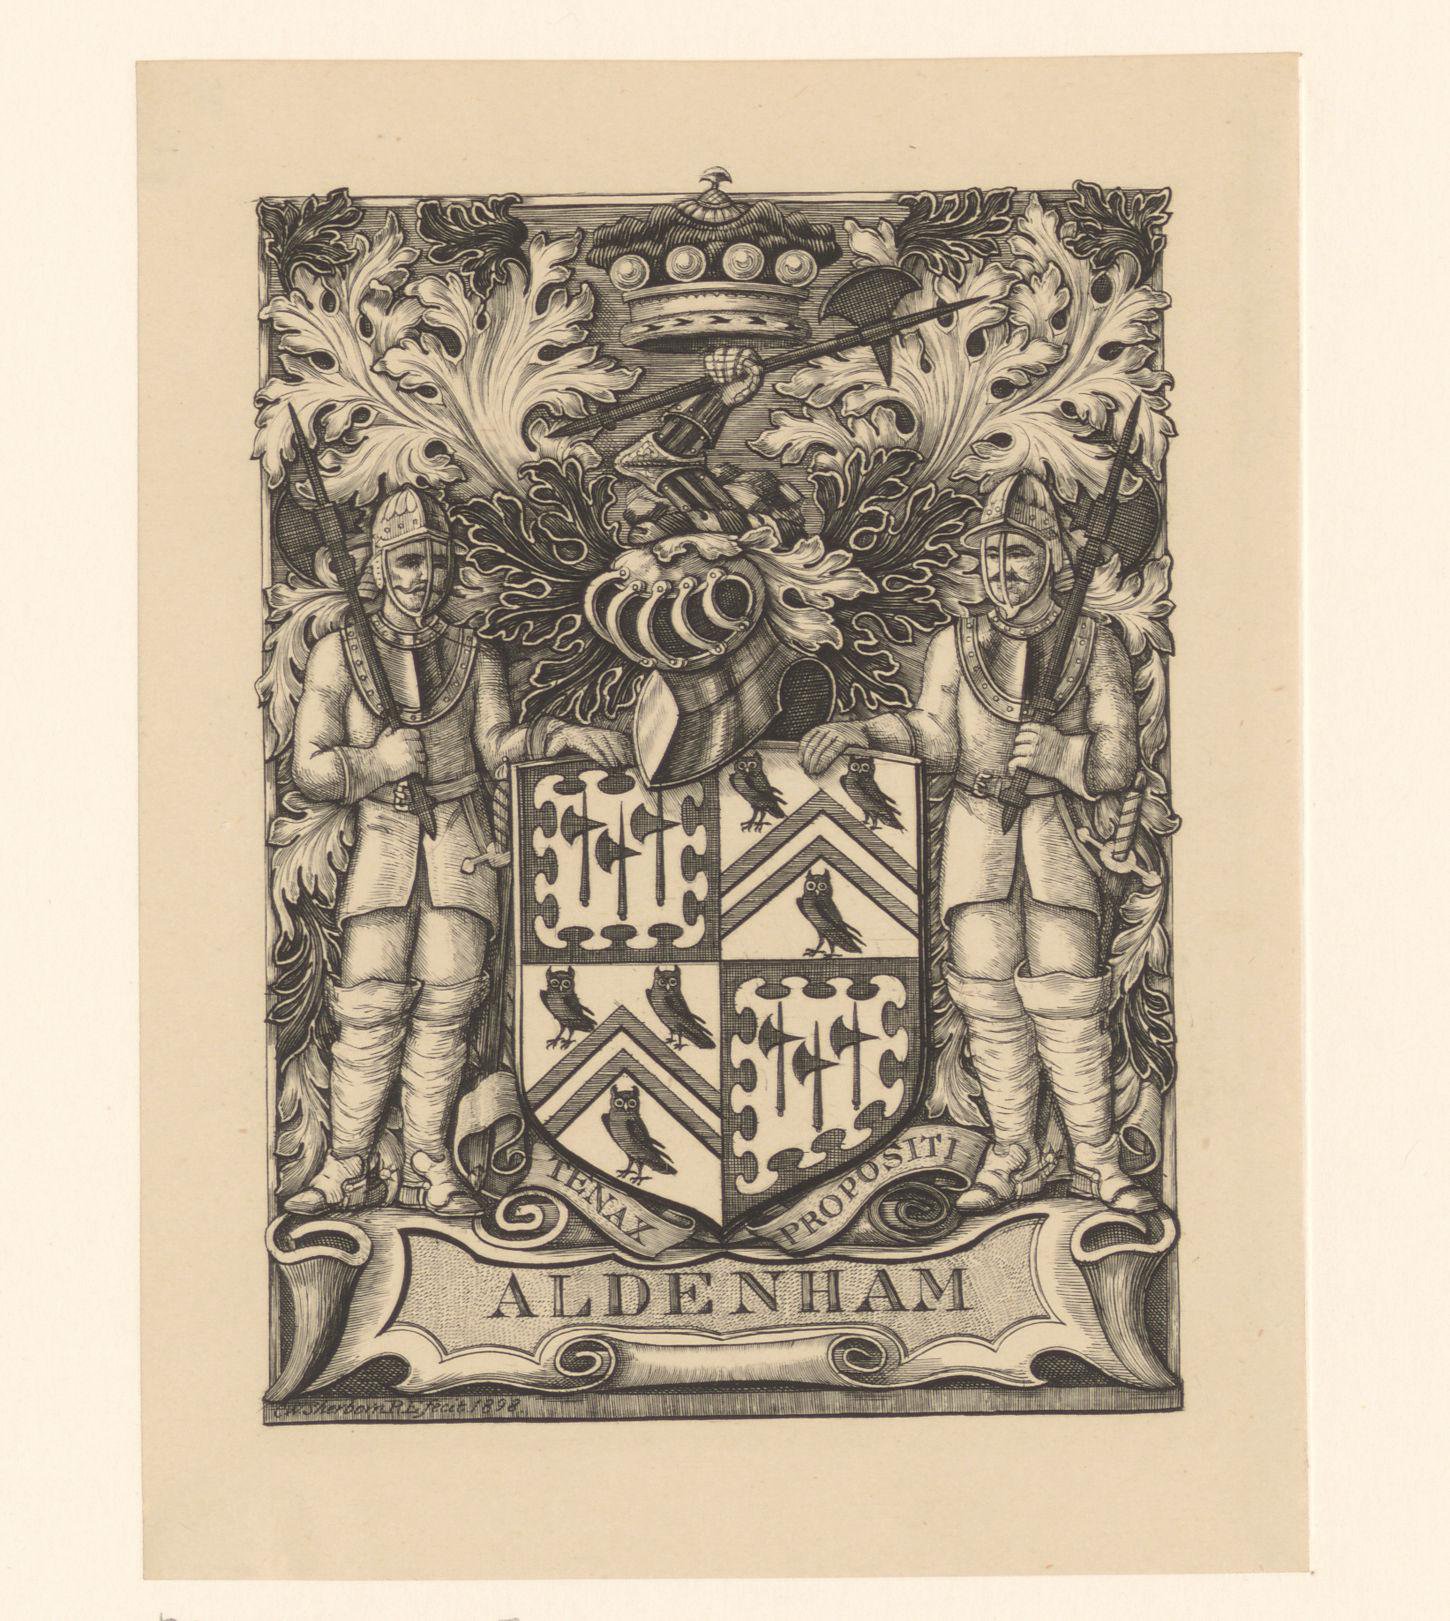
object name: bookplate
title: Tenax propositi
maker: charles william sherborn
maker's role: print maker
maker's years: 1831-1912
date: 1898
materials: paper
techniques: engraving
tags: politician, foliage ~ ornament, the soldier; the soldier's life, armorial bearing, heraldry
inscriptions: collector's mark: Lugt 2228